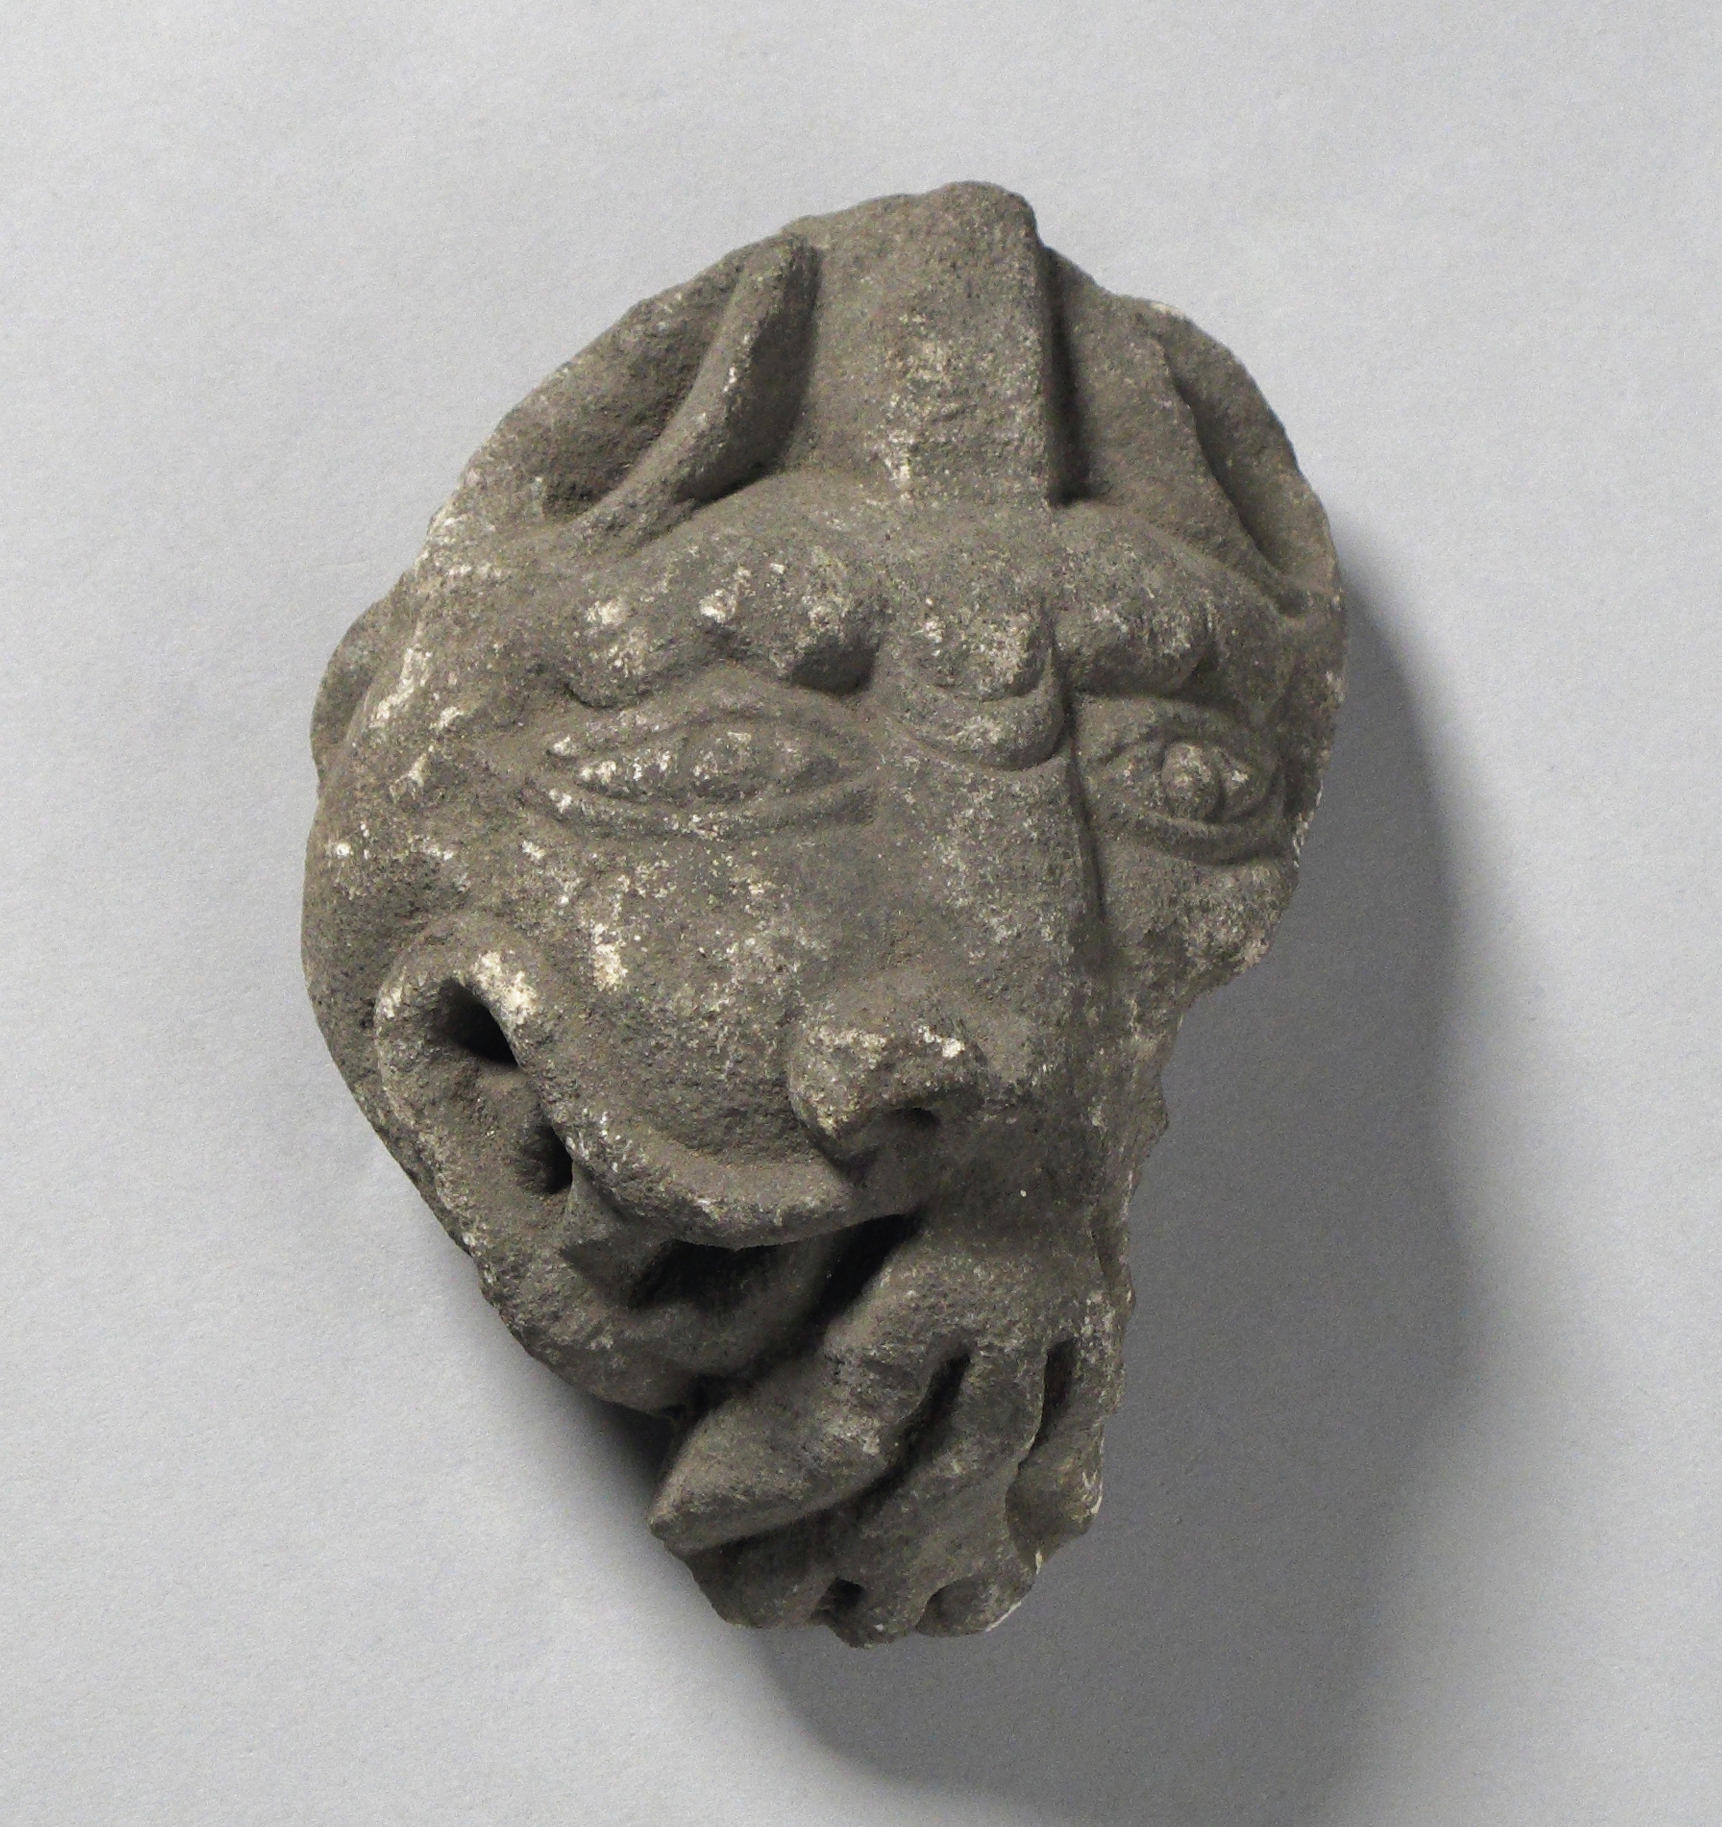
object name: corbel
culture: catalan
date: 1151-1200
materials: stone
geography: france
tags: animals